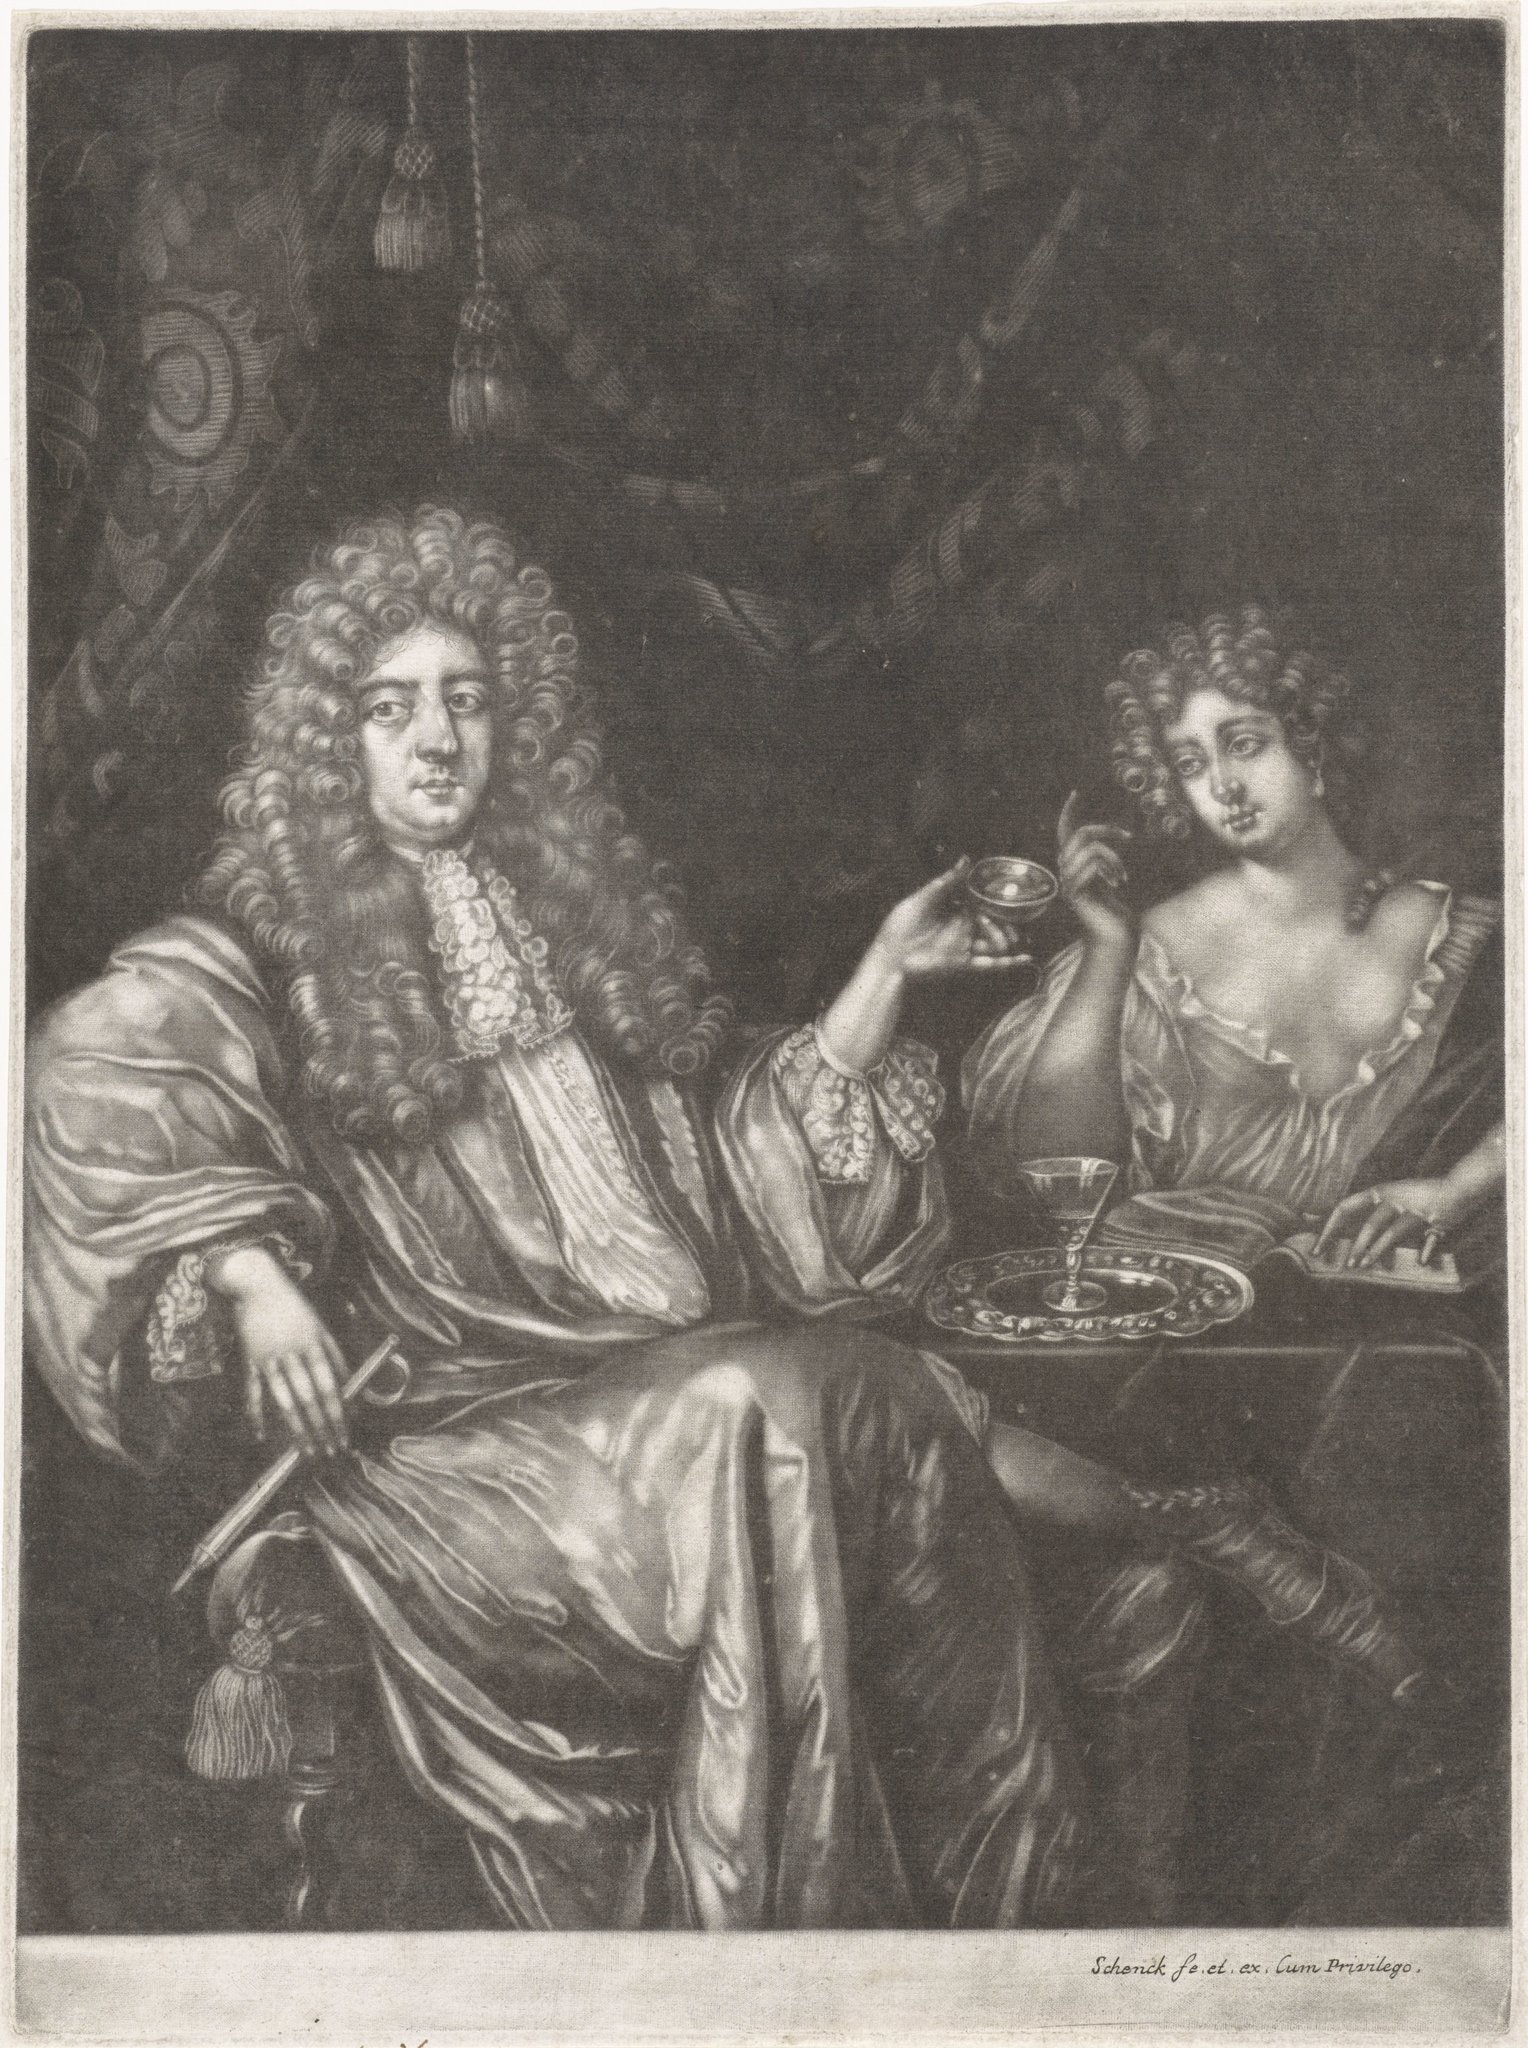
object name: print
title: Portrait of a Man with a Prostitute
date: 1670-1713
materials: paper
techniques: engraving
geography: amsterdam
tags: book, mistress, wig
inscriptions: collector's mark: Lugt 2760, collector's mark: Lugt 1425, collector's mark: Lugt 2228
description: De schrijver van theologische werken en hekelschriften Hadriaan Beverland, met een dame van lichte zeden. De schrijver zit aan een tafel waarop een glas op een blad. De jonge vrouw heeft haar bovenkleding losgeknoopt en heeft een opengeslagen boek voor zich.